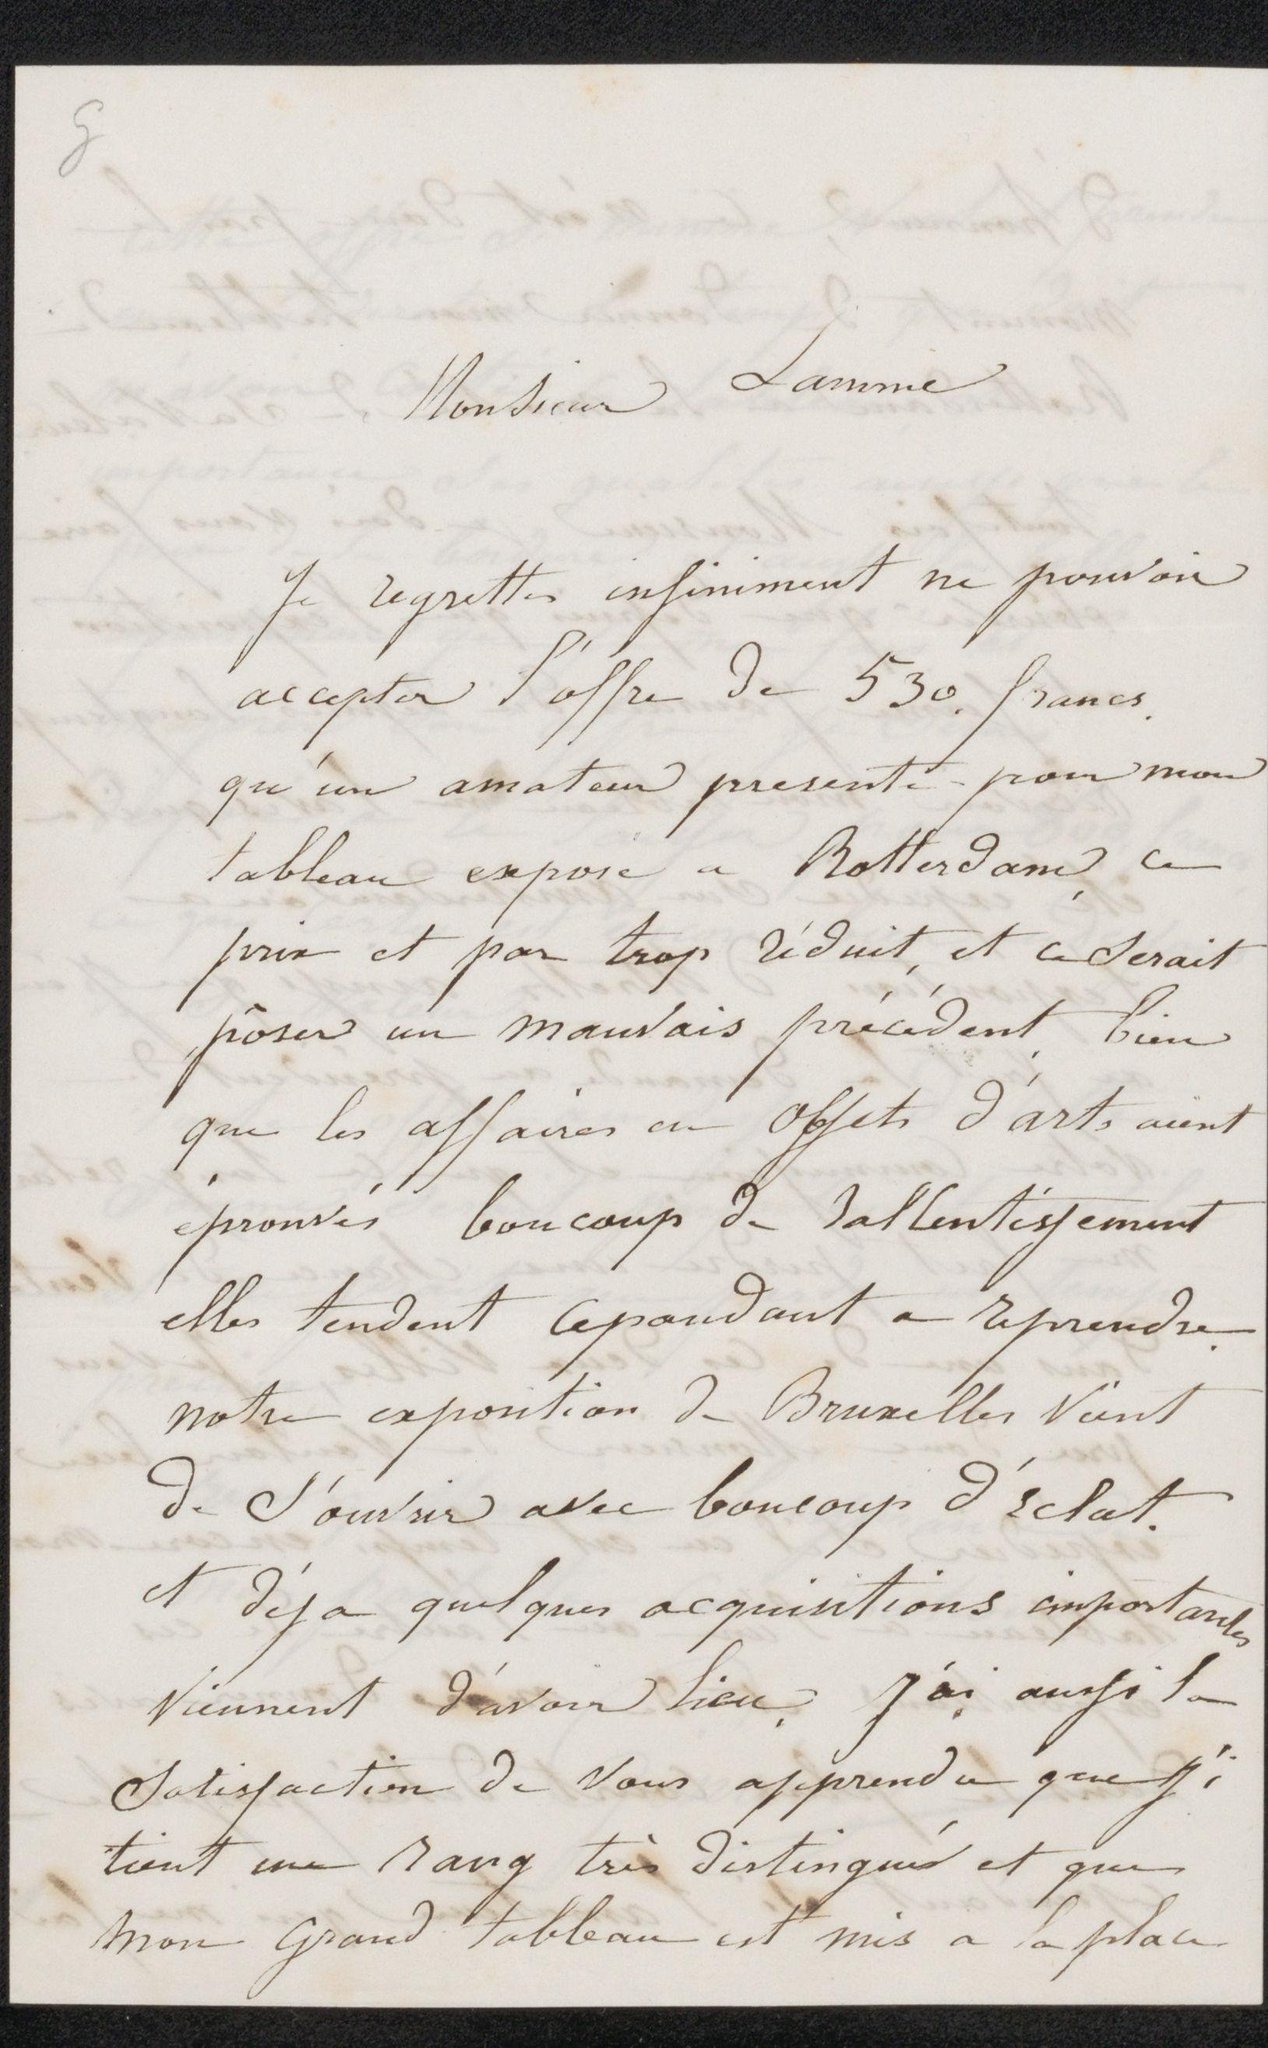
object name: letter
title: Brief aan Ary Johannes Lamme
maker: jules victor genisson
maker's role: painter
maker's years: 1805-1860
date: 1822-1860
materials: ink, paper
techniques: pen, writing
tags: dordrecht, print maker, draughtsman, ary johannes lamme, art trade, art shop, painting (including book-illumination, miniature-painting), exhibition ~ art, rotterdam, brussels, utrecht, amsterdam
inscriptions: collector's mark: Lugt 2228